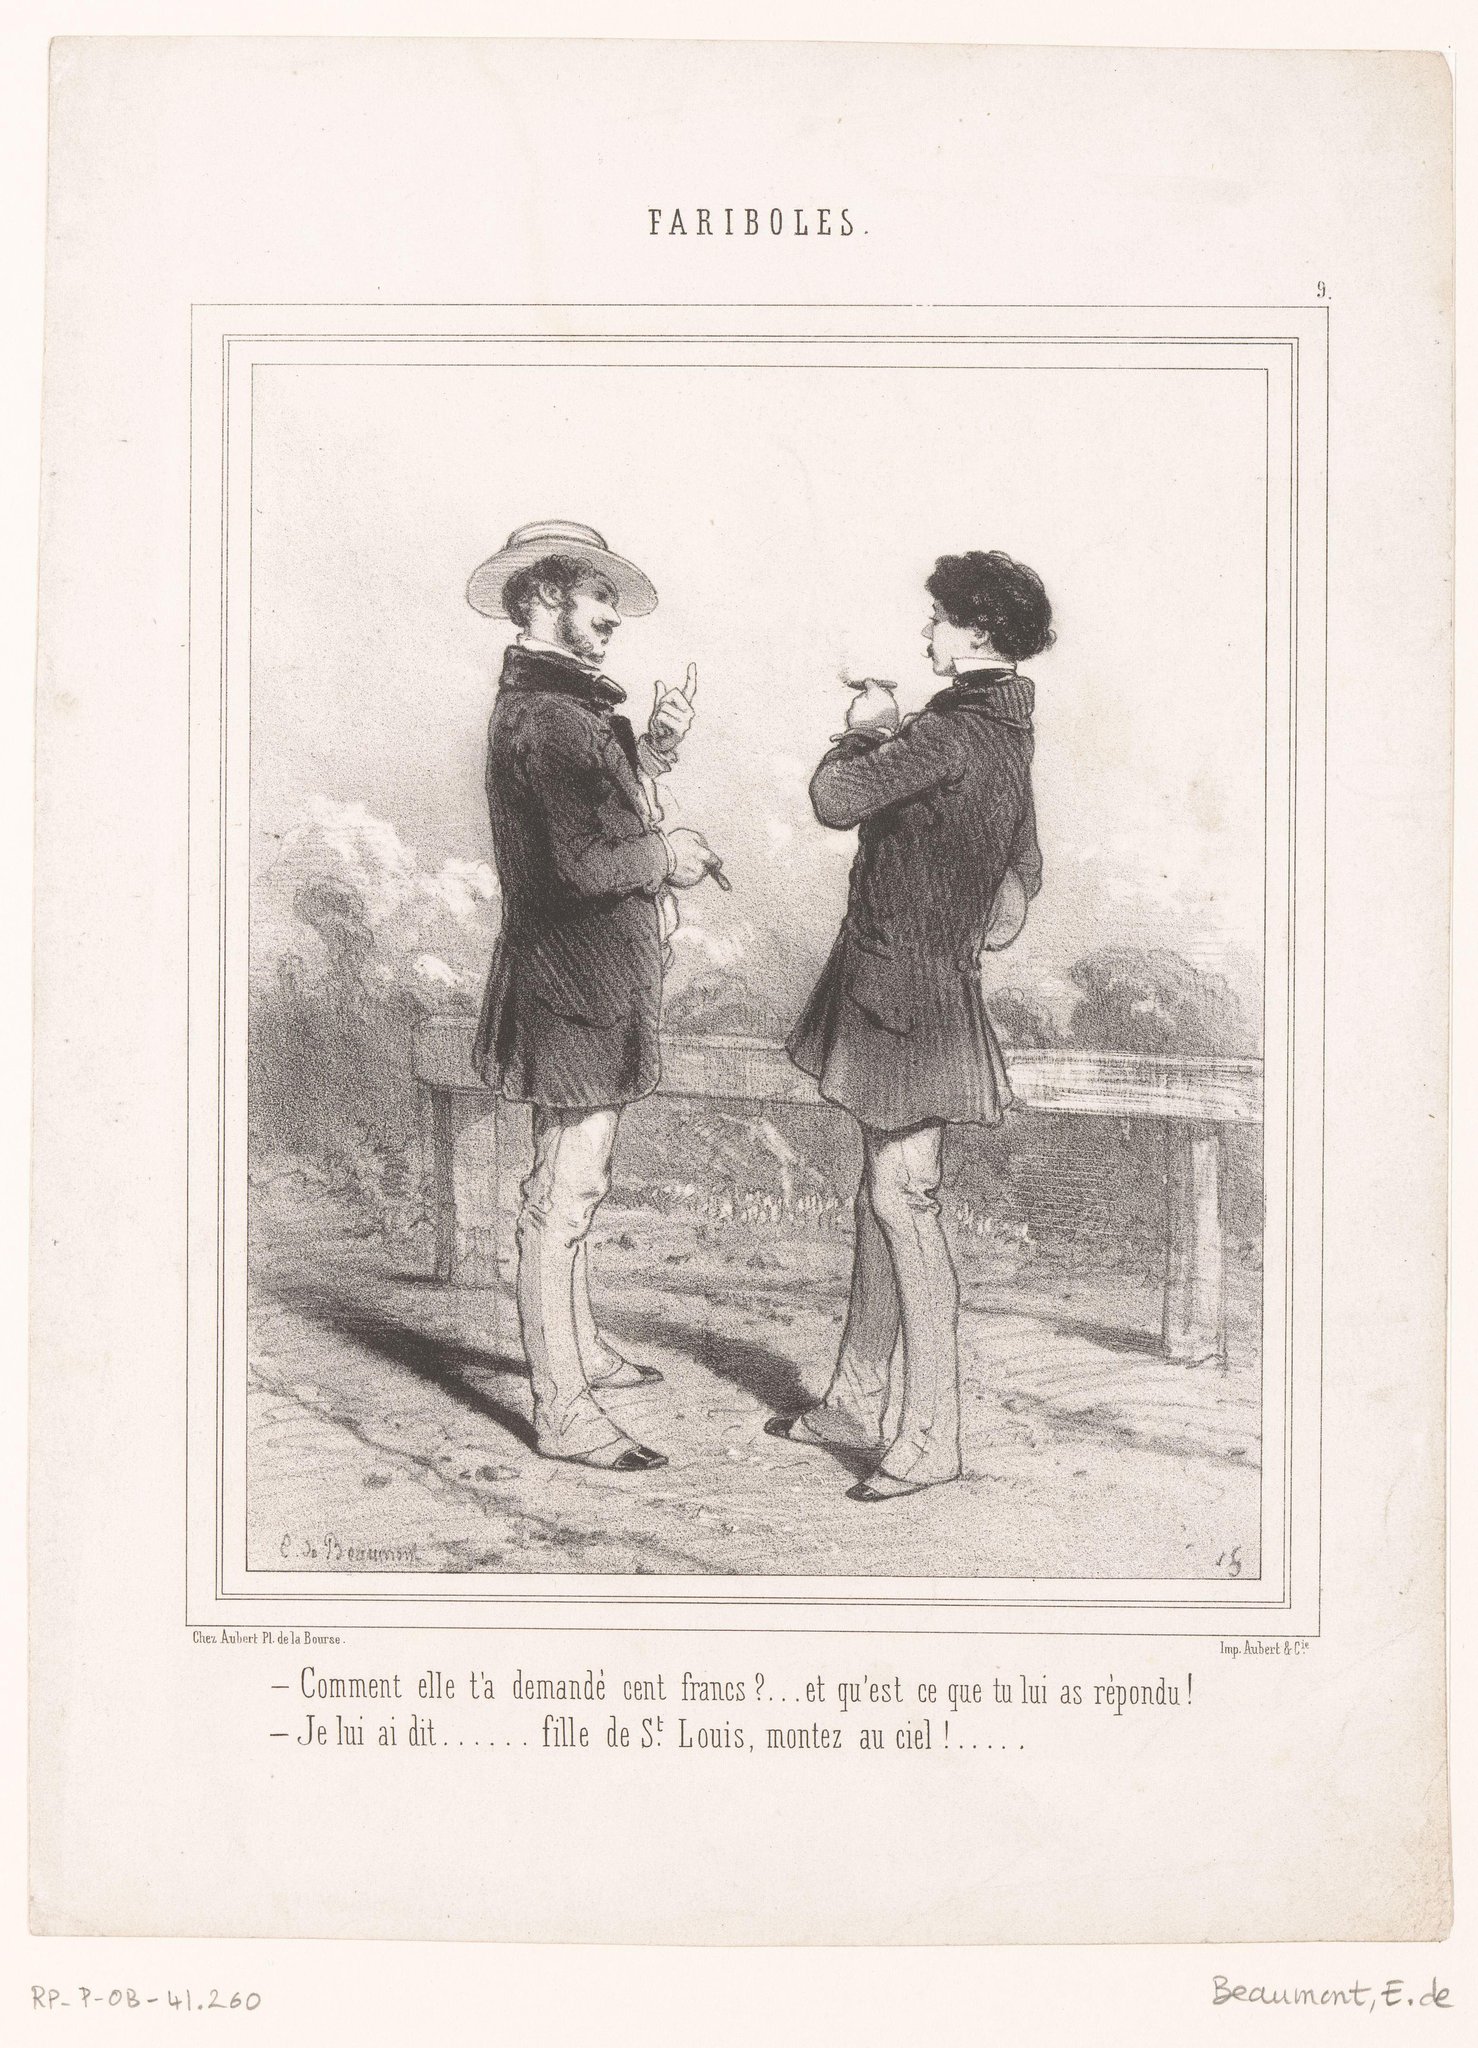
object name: print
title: Kletspraatjes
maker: edouard de beaumont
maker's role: draughtsman, painter, print maker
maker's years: 1812-1888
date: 1847-1851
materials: paper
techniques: lithograph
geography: paris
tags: cigar, adult man, conversation, dialogue; conversation piece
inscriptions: collector's mark: Lugt 2228a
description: De heren converseren over een meisje, dat een van hen om geld heeft gevraagd.